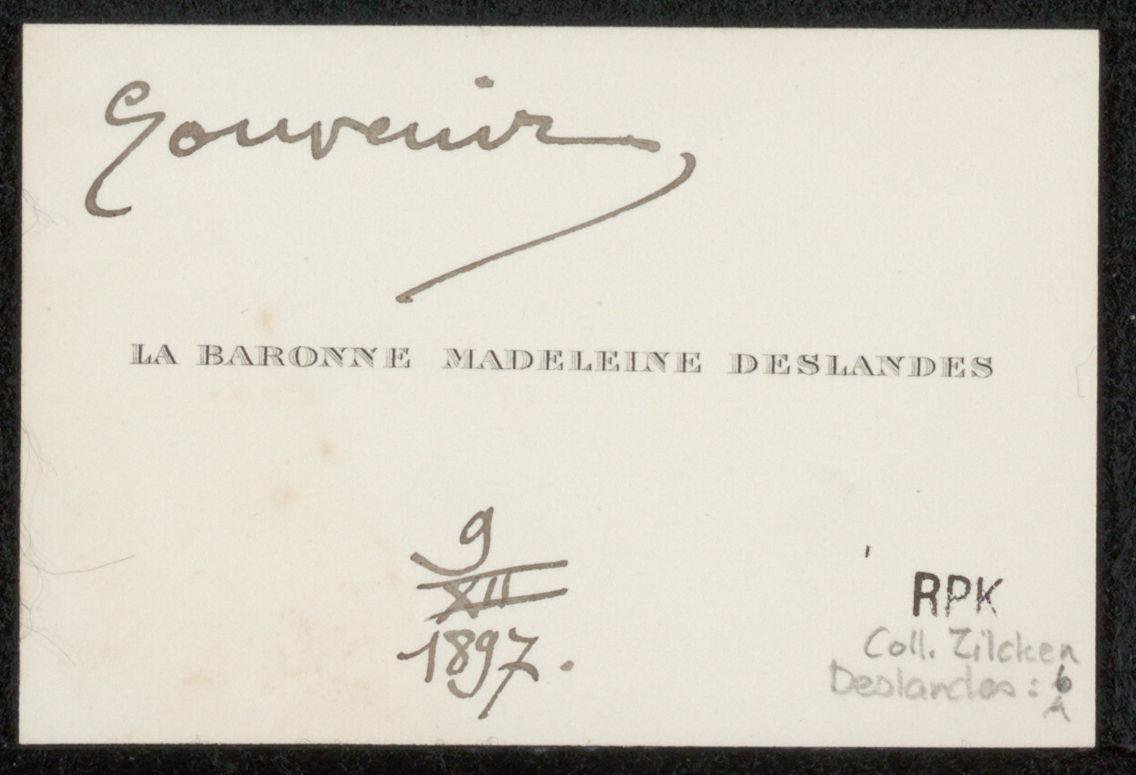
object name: visiting card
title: Visitekaartje aan Philip Zilcken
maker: baronne madeleine deslandes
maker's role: schrijver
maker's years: 1866-1929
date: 1897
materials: ink, paper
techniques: pen, printing, writing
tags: painter, draughtsman, philip zilcken, photography, cinematography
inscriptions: collector's mark: ‘RPK’